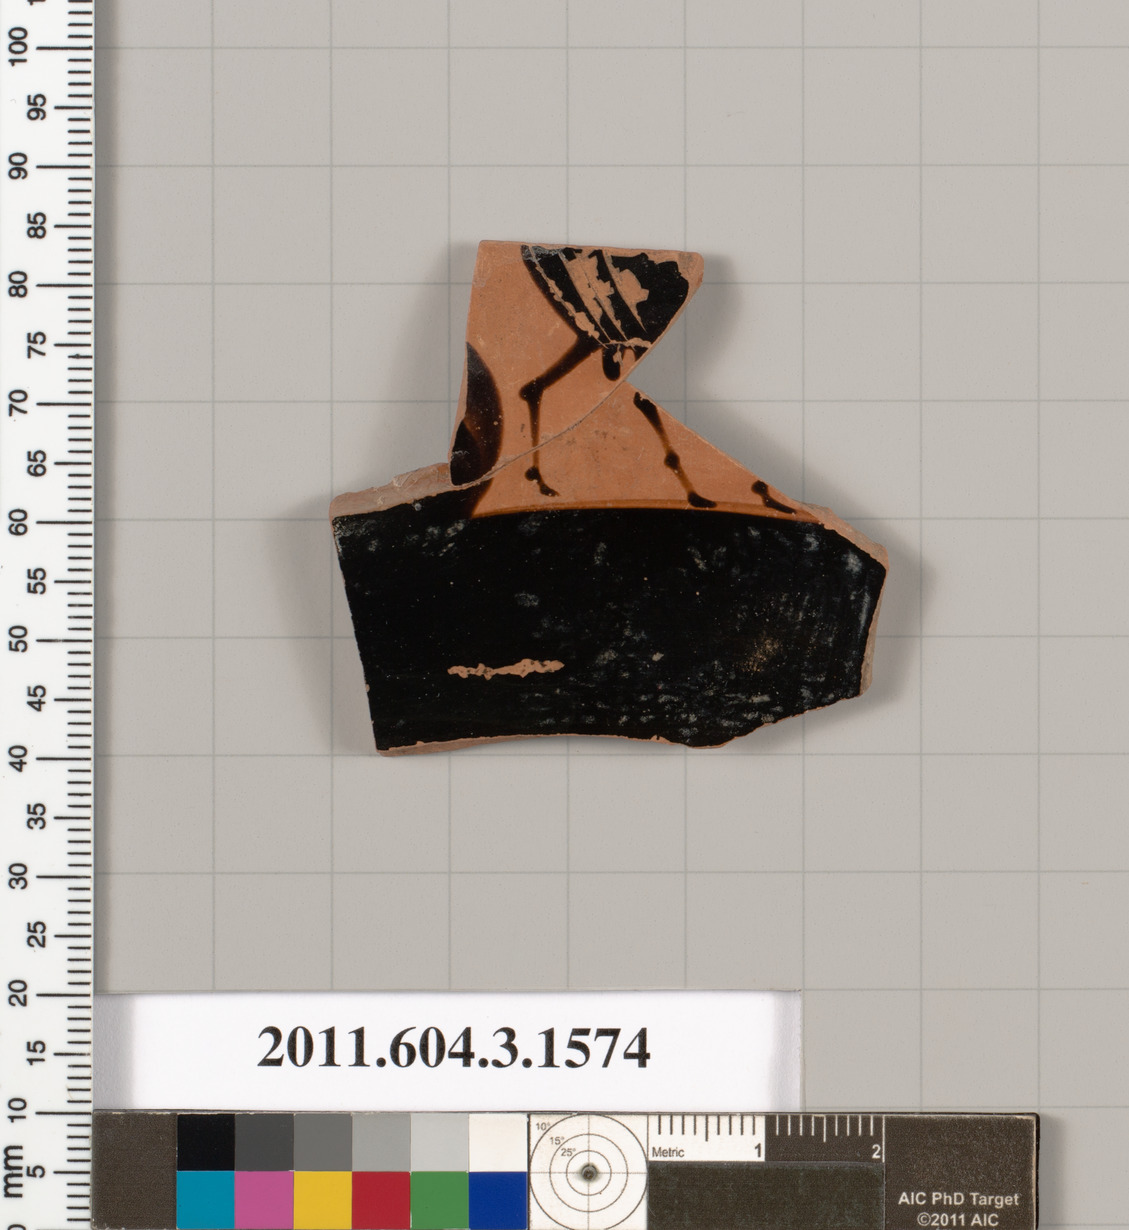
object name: kylix fragment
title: Terracotta fragment of a kylix: Band cup (drinking cup)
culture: greek, attic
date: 550-526 BCE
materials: terracotta